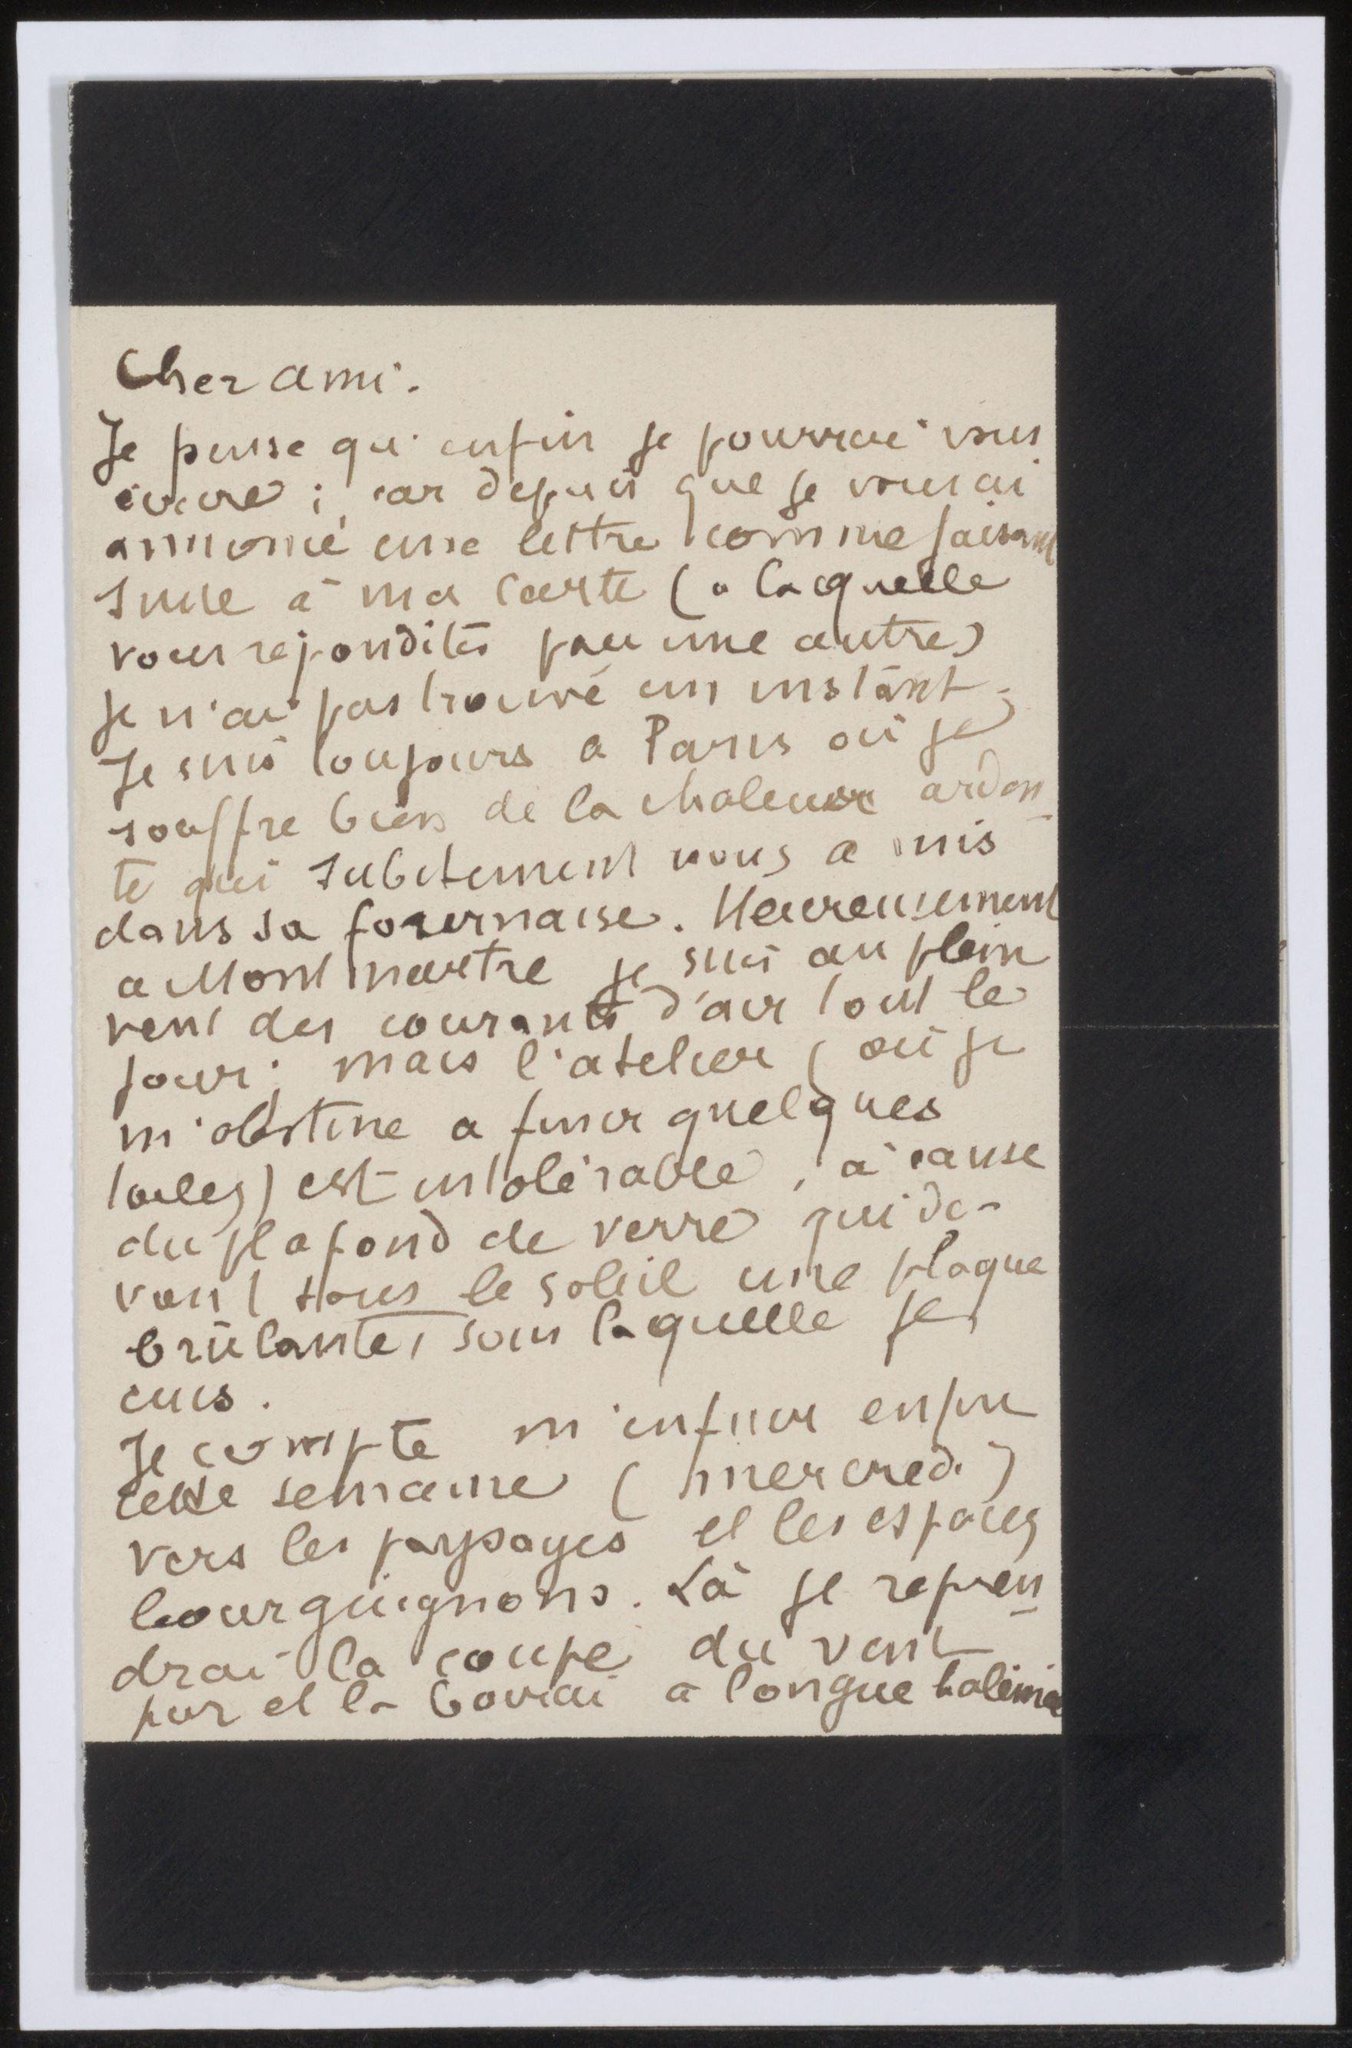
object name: letter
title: Brief aan Andries Bonger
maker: émile bernard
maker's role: print maker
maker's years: 1868-1941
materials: ink, paper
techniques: pen, writing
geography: paris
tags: amsterdam, andries bonger, applied arts, arts and crafts; industrial design, family life, workshop, studio of the artist (in general), money, paris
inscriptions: watermark